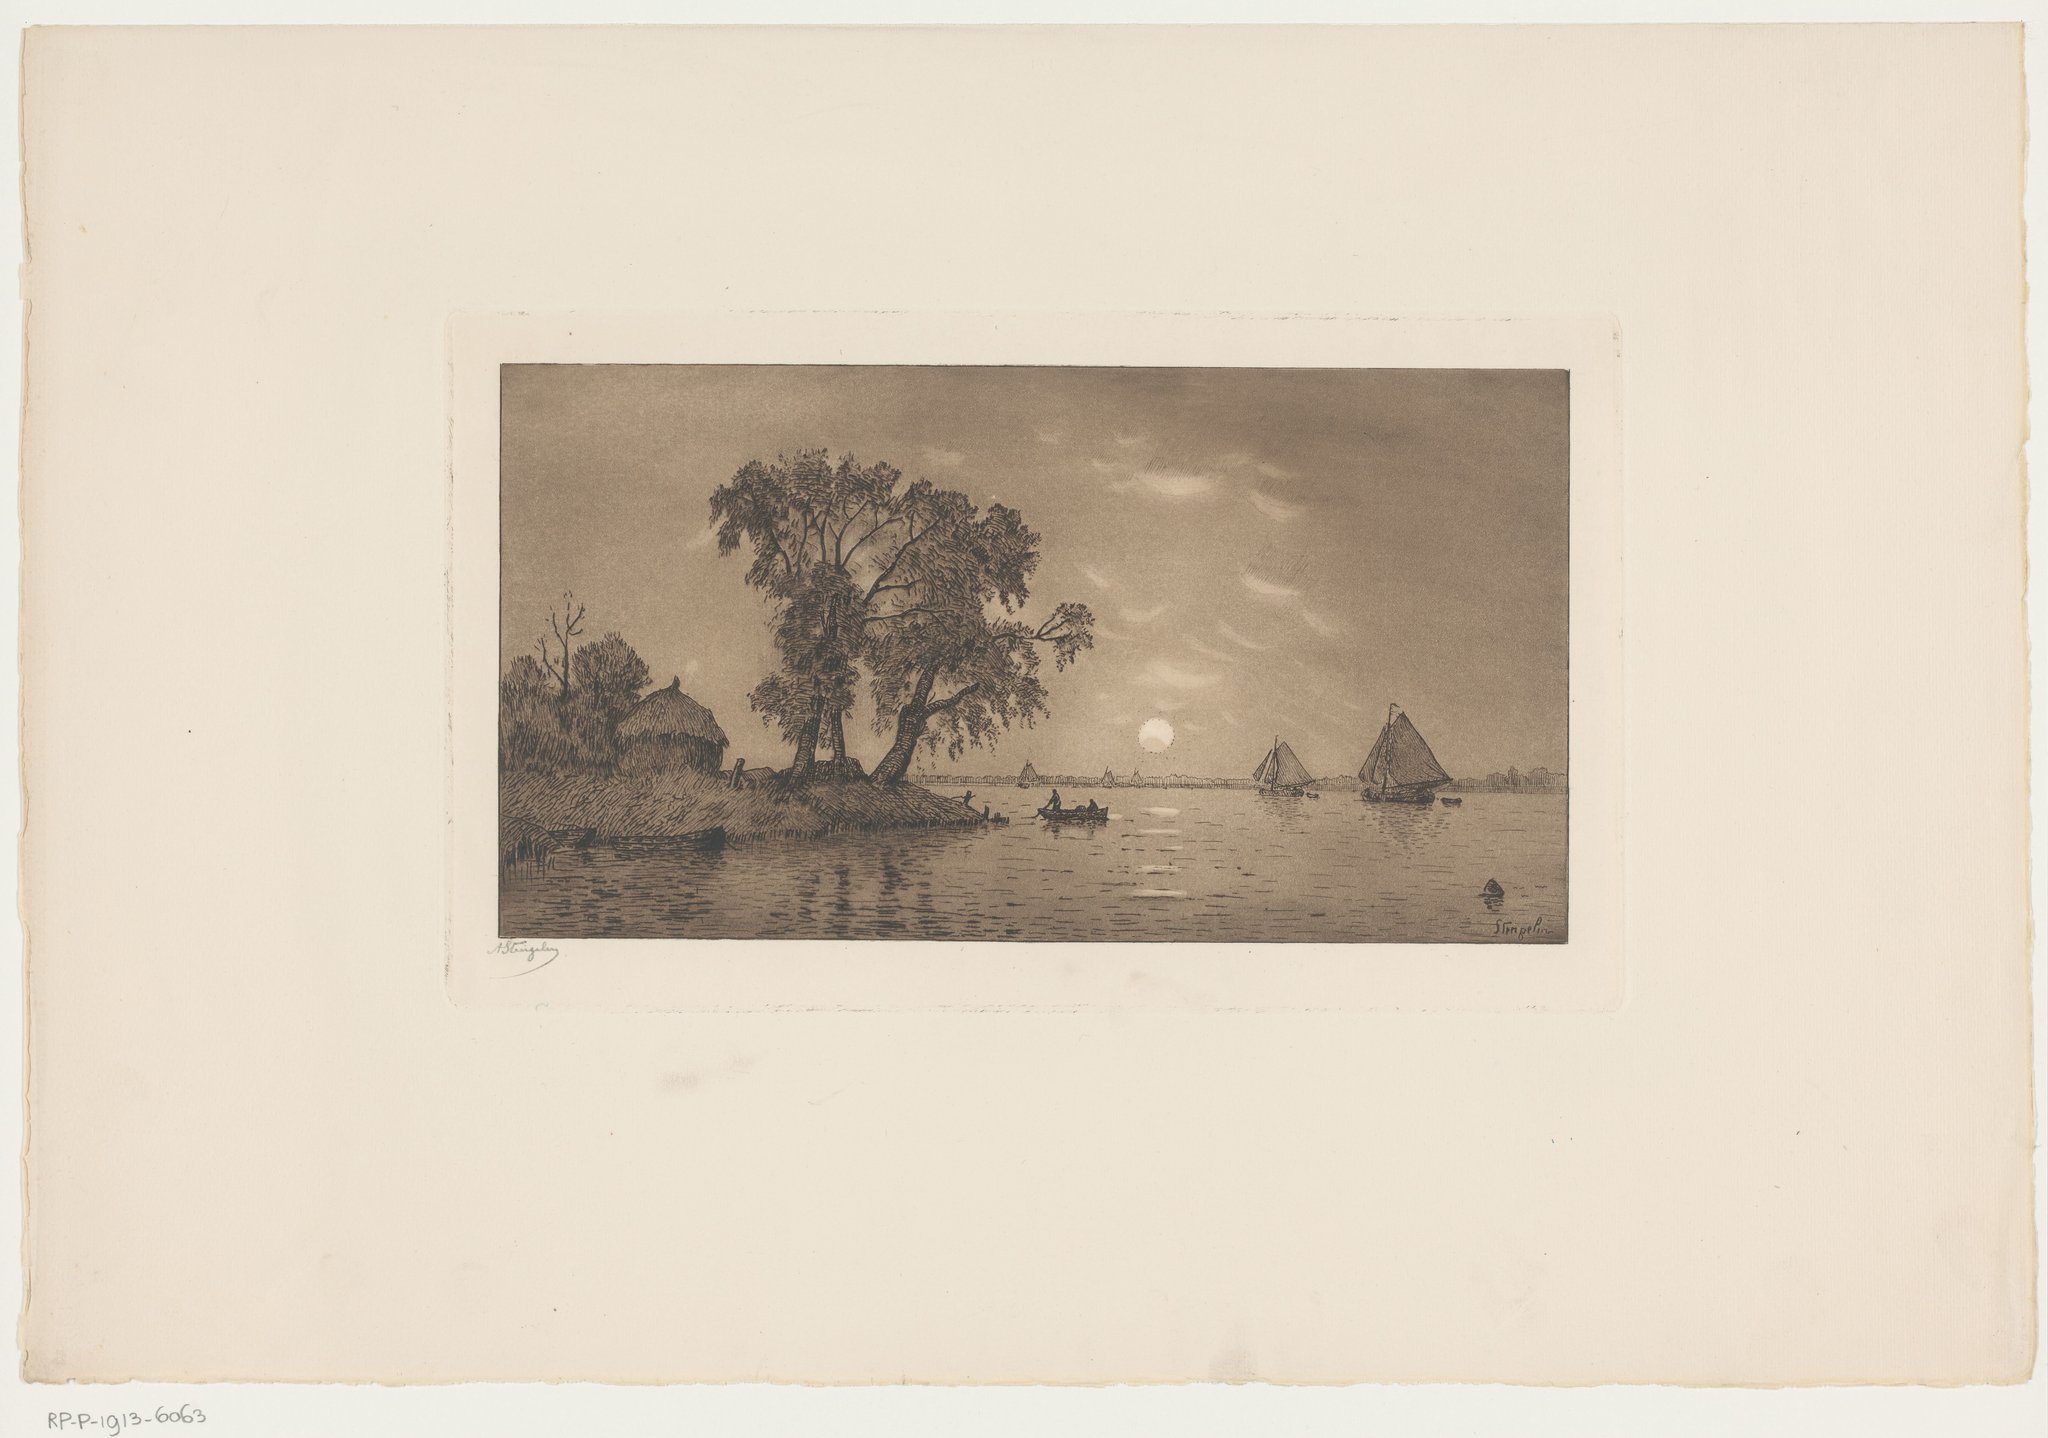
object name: print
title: Landschap met rivier bij zonsondergang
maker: alphonse stengelin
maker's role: painter, print maker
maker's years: 1852-1938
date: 1862-1913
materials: paper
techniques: aquatint, etching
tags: river, sunset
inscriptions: collector's mark: Lugt 2233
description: Landschap met links een stuk land met een hooiberg en drie grote bomen, in het water een roeiboot en enkele zeilboten.